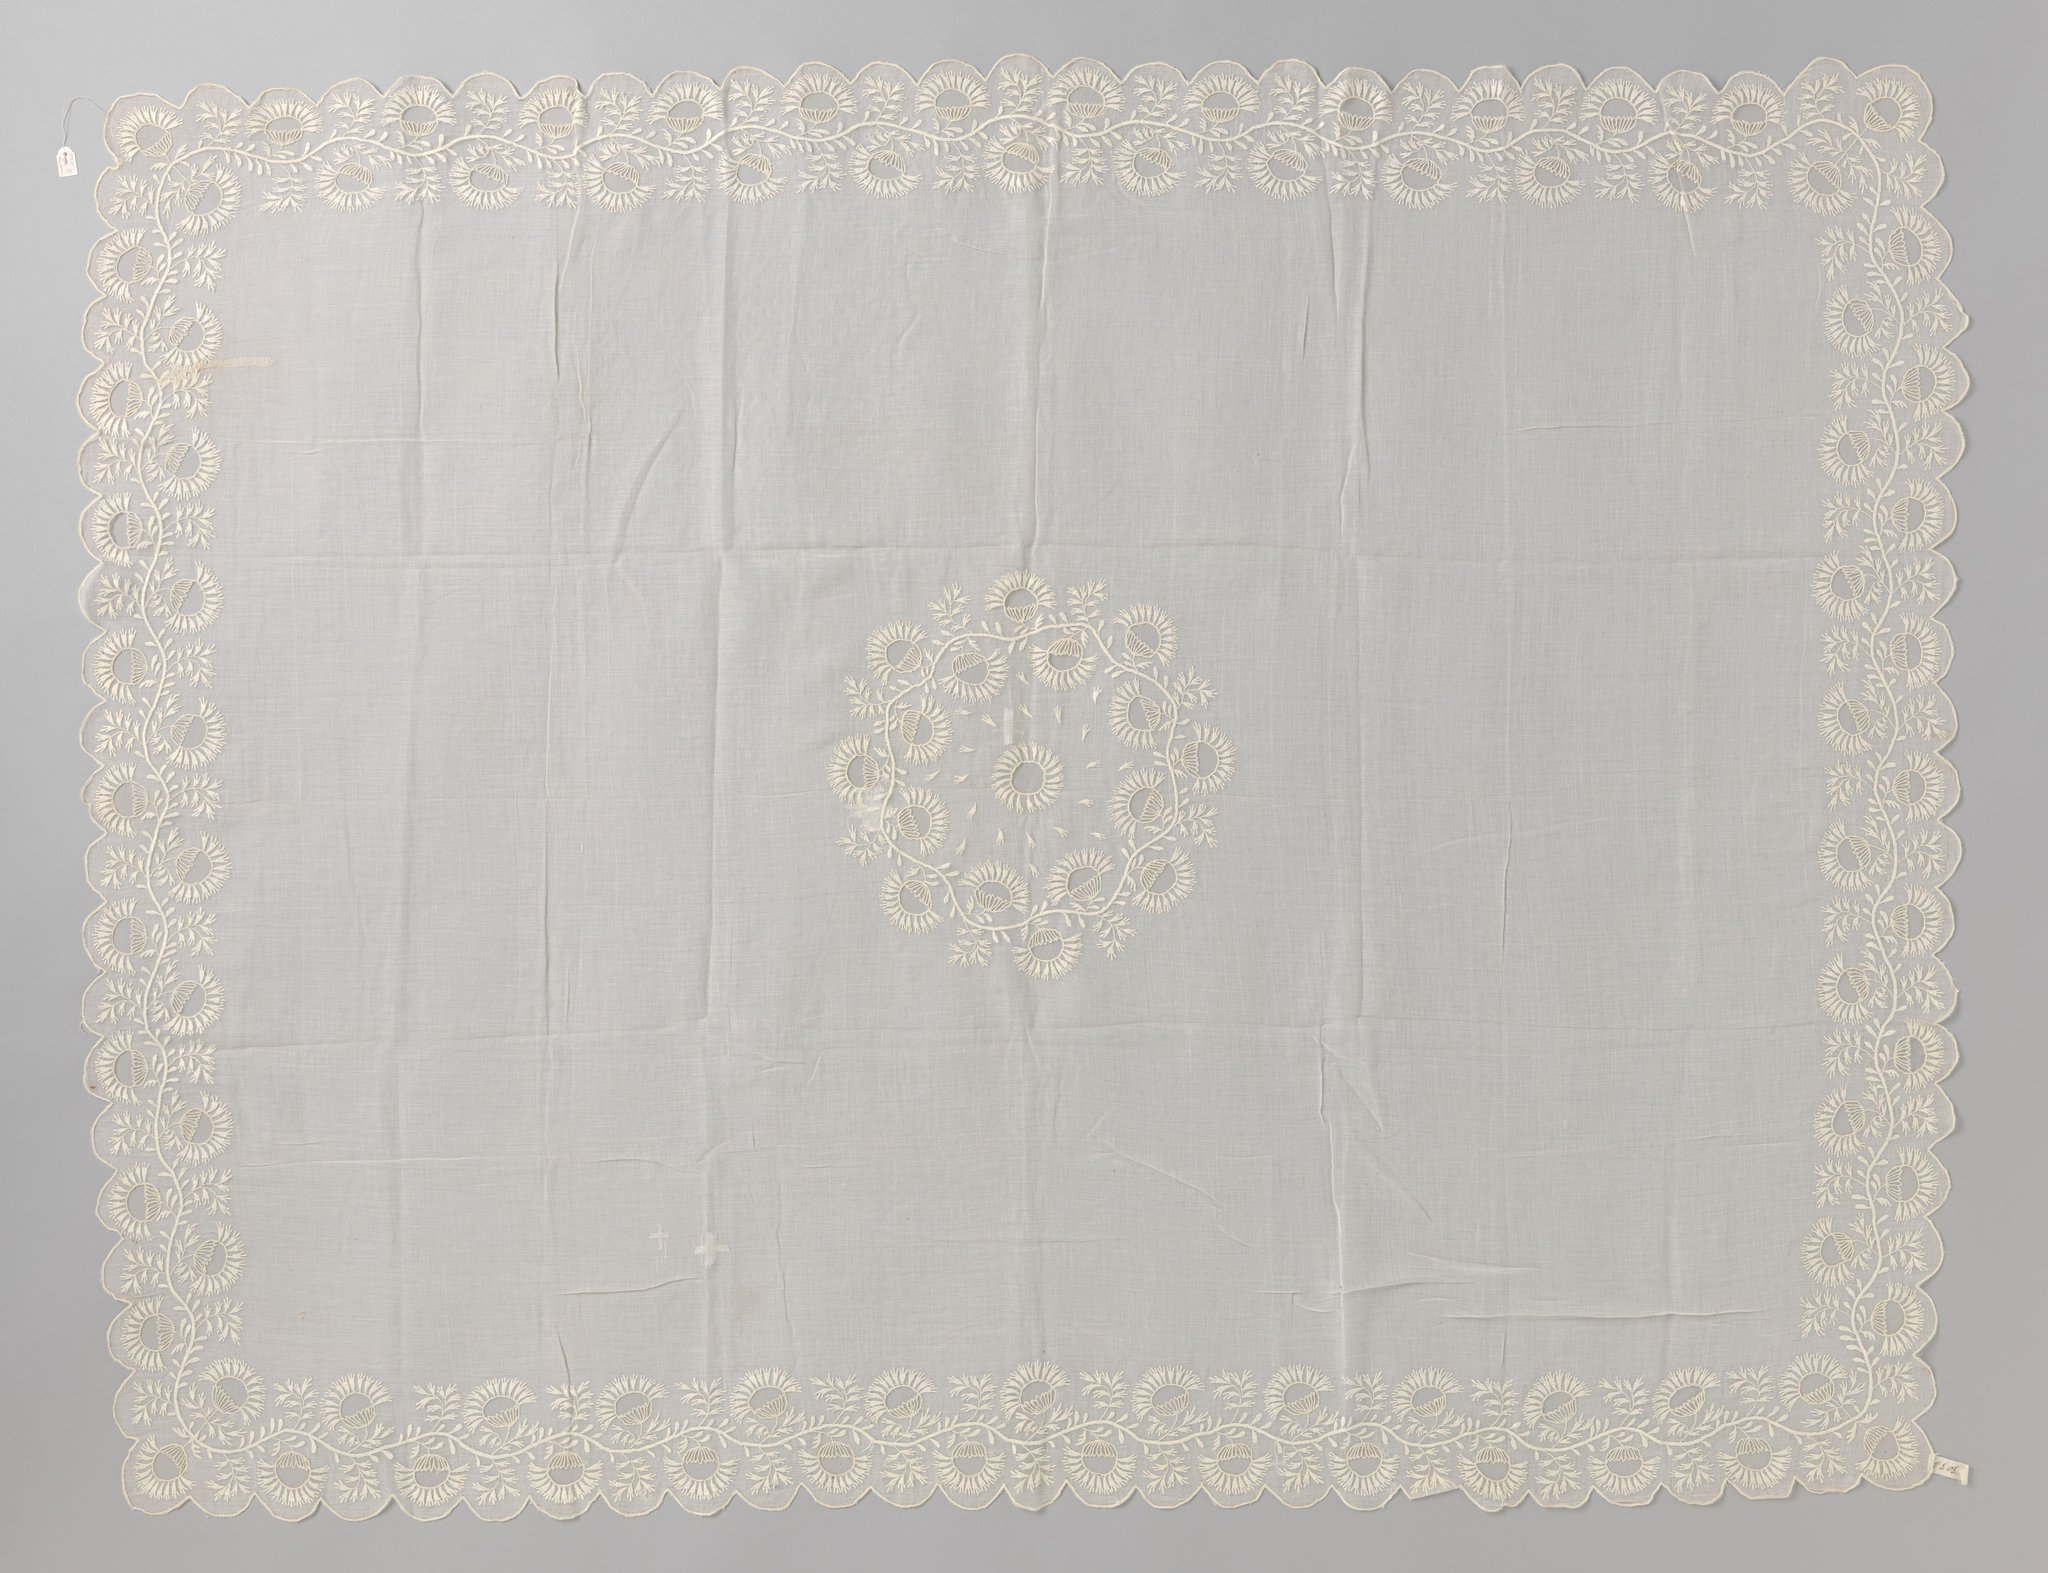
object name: doopkleed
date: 1835-1840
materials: cotton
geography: netherlands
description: Een doopkleed met schulpranden en een middenmotief. Horend bij een doopjurk: inv. nr. BK-1980-1-A.